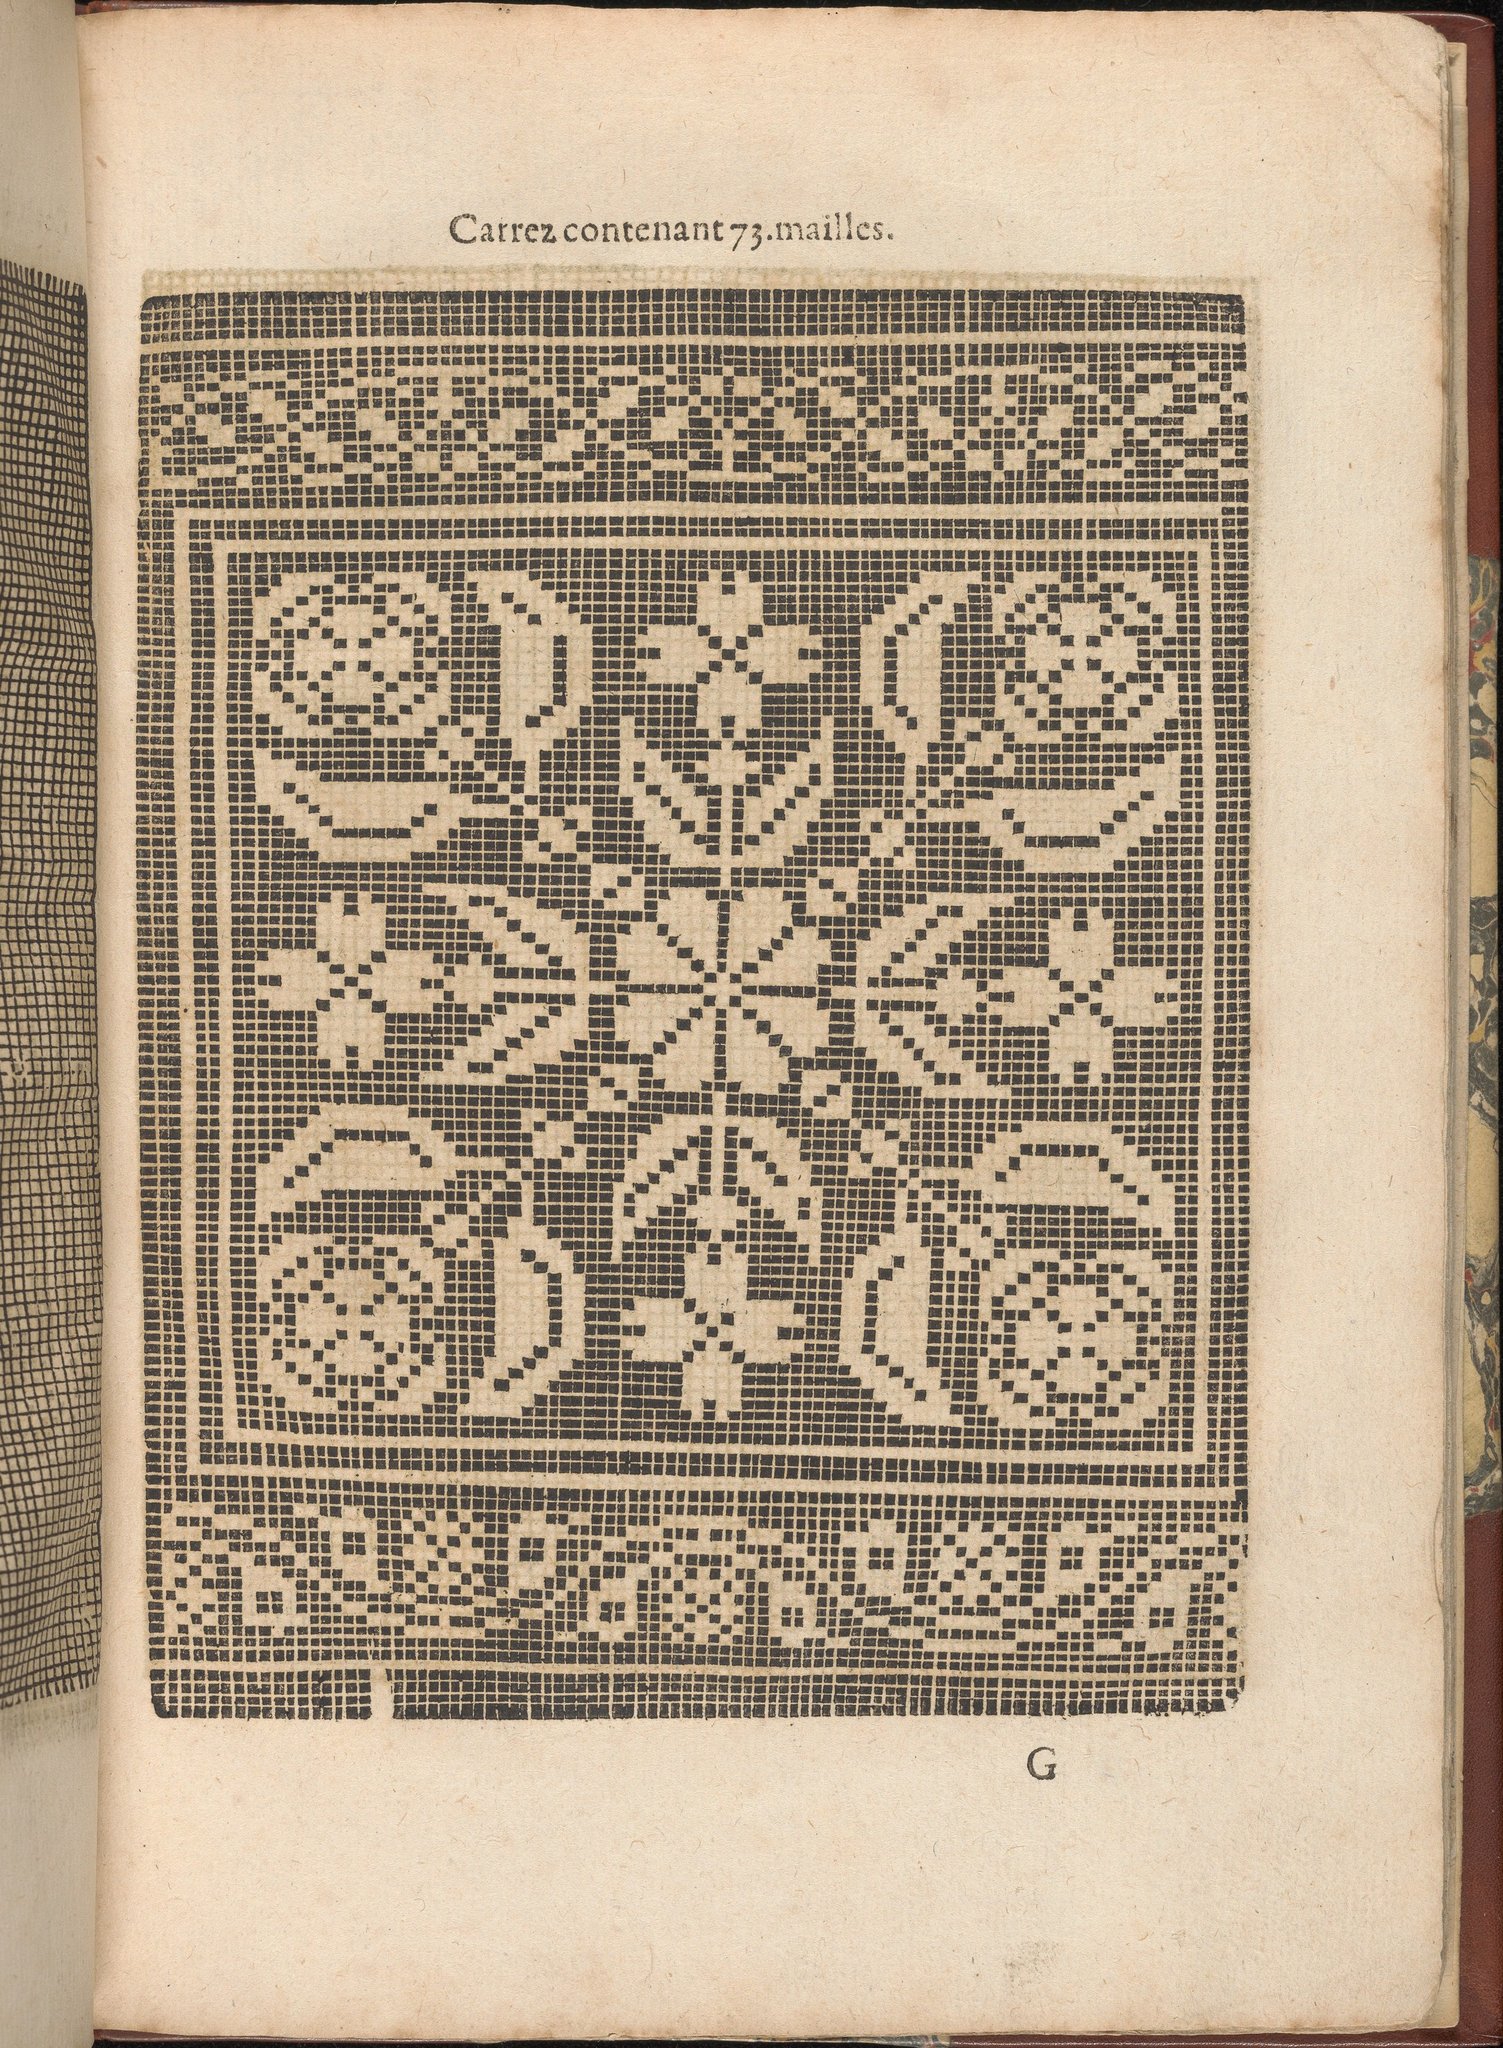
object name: book print ornament architecture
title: Les Secondes Oeuvres, et Subtiles Inventions De Lingerie du Seigneur Federic de Vinciolo Venitien, page 25 (recto)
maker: federico de vinciolo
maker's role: designer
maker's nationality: italian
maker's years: 1582-1599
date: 1603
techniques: woodcut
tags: flowers